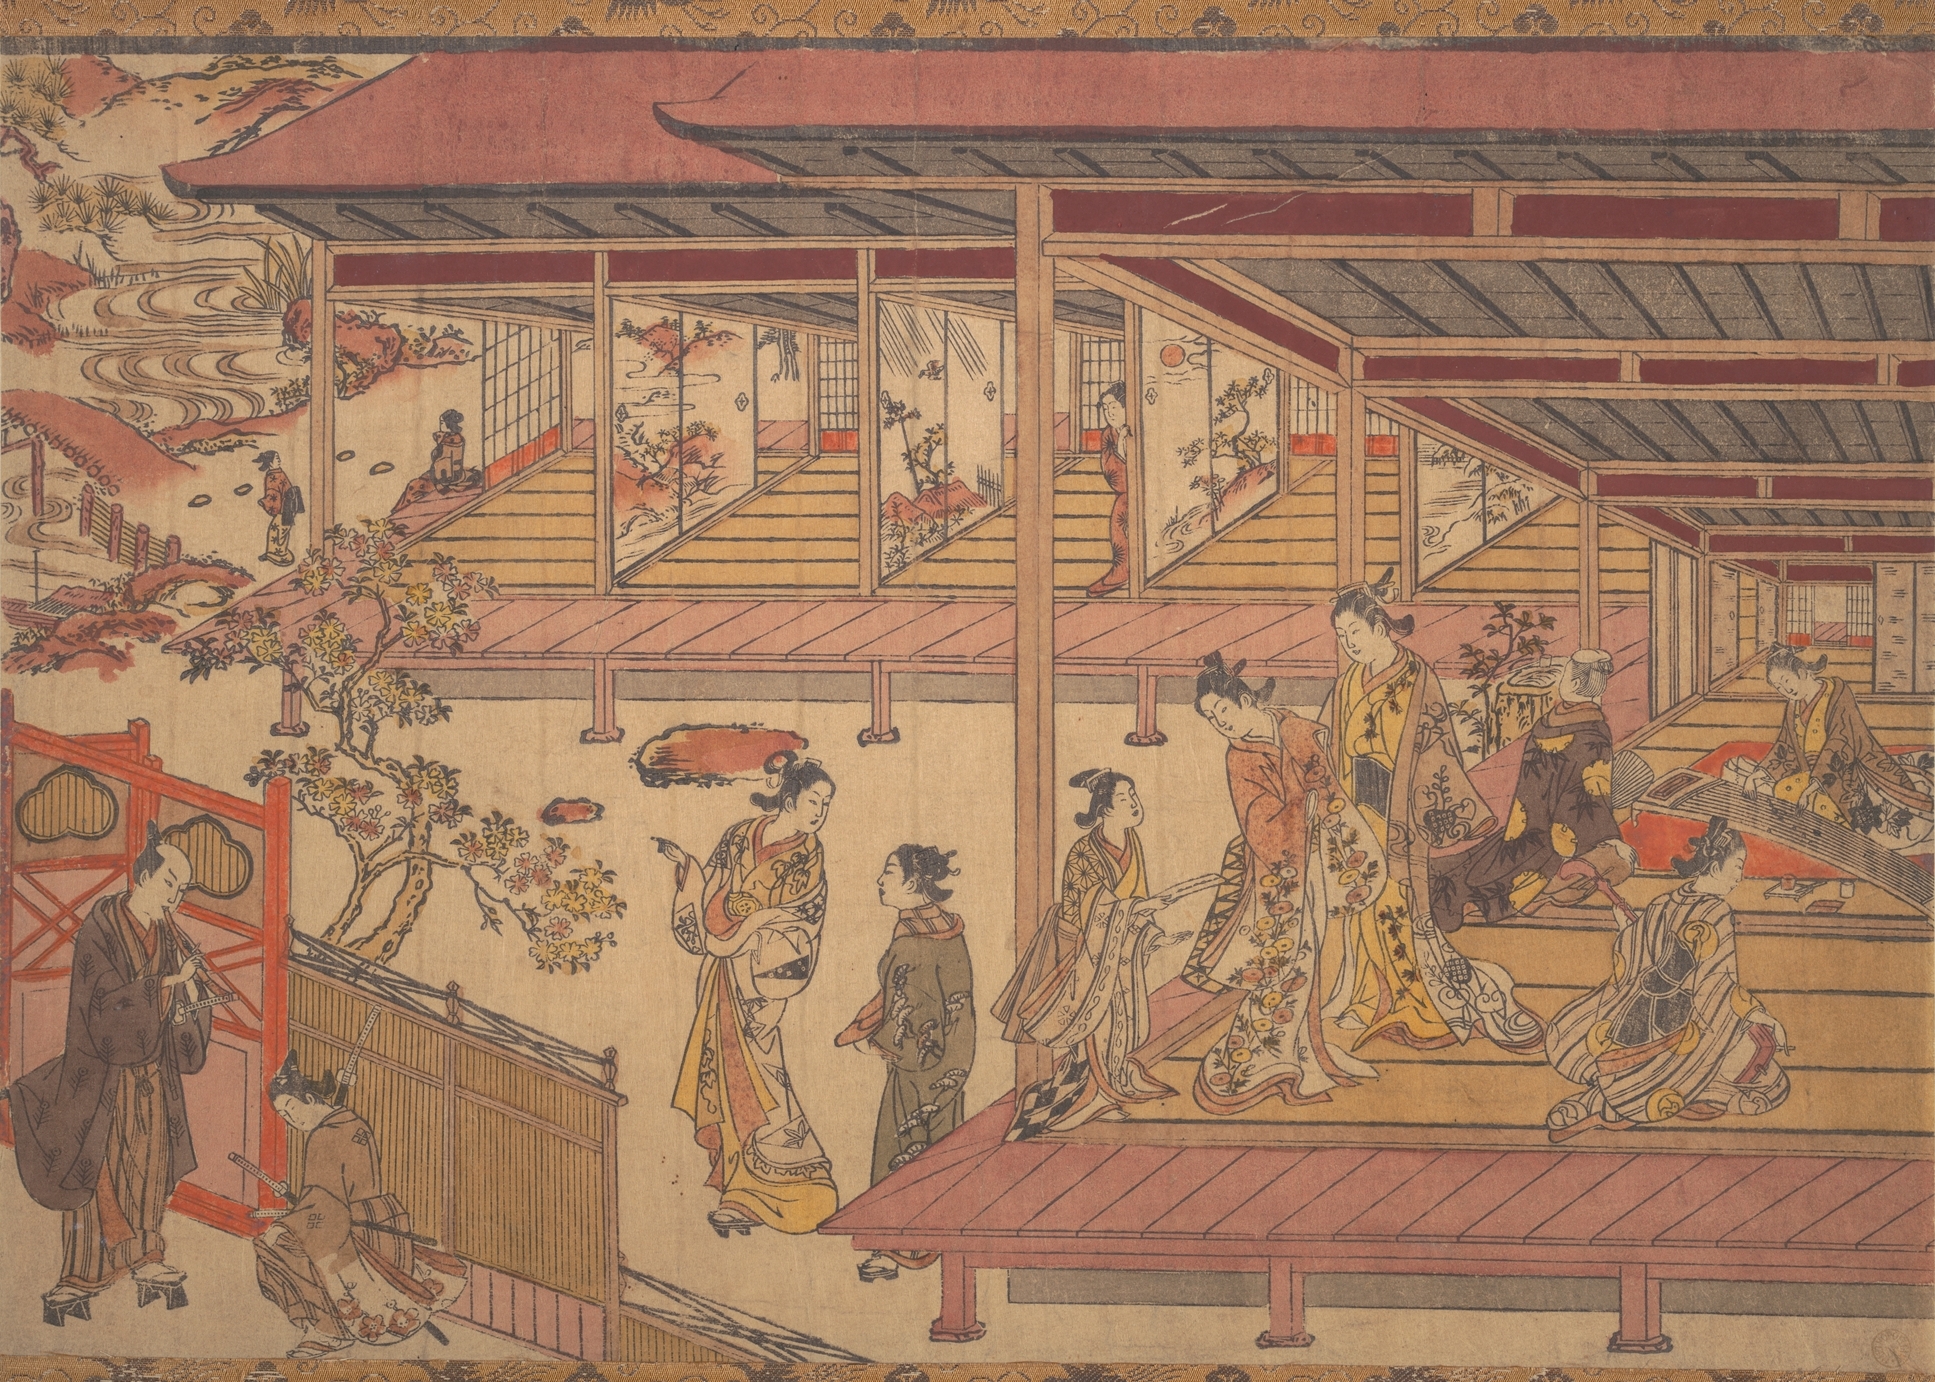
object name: print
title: A Man Standing Outside the Gate of a Large House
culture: japanese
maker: okumura masanobu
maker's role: artist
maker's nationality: japanese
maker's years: 1686-1764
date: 1738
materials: ink, paper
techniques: hand coloring, woodblock print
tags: gates,houses,men,women,trees